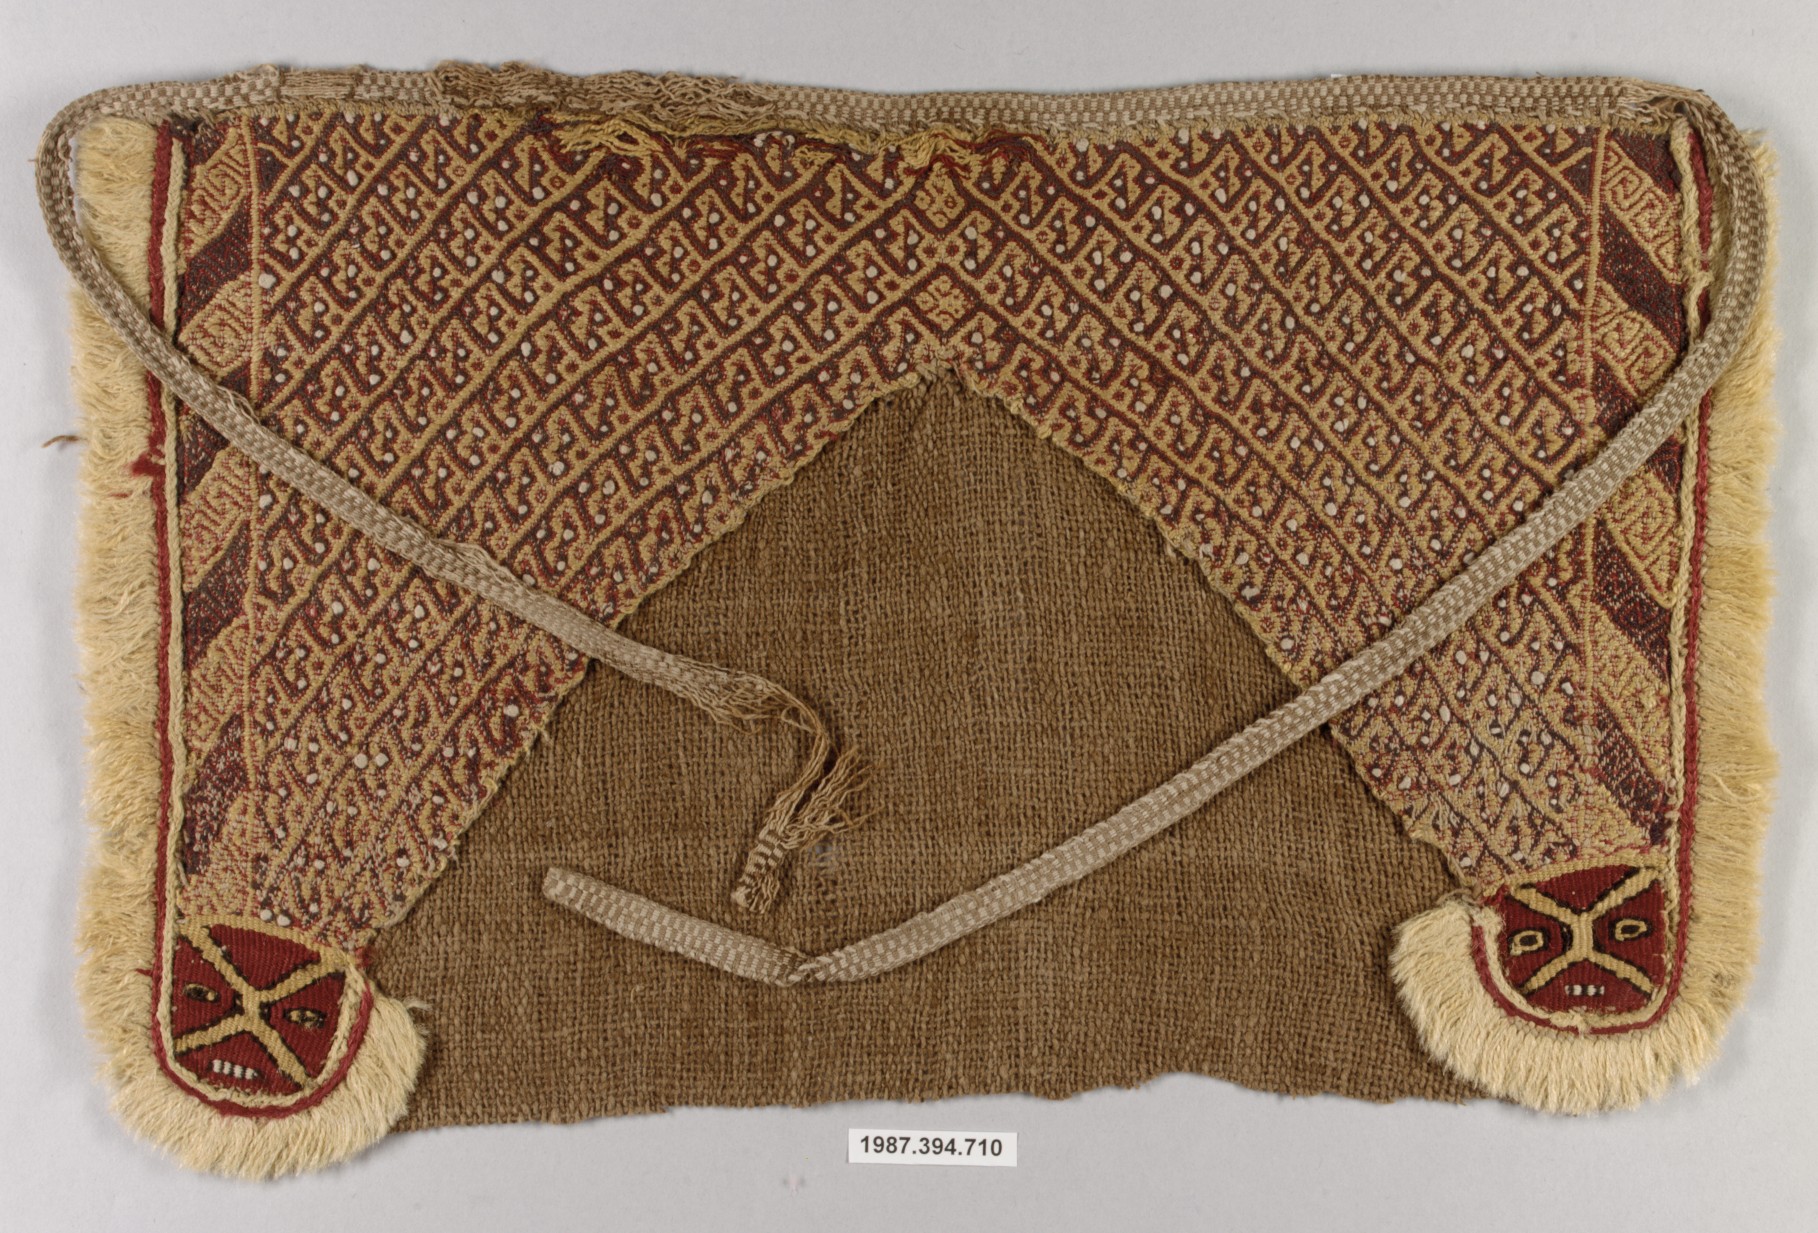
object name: panel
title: Tapestry Panel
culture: peruvian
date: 1101-1500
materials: animal fiber, cotton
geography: peru